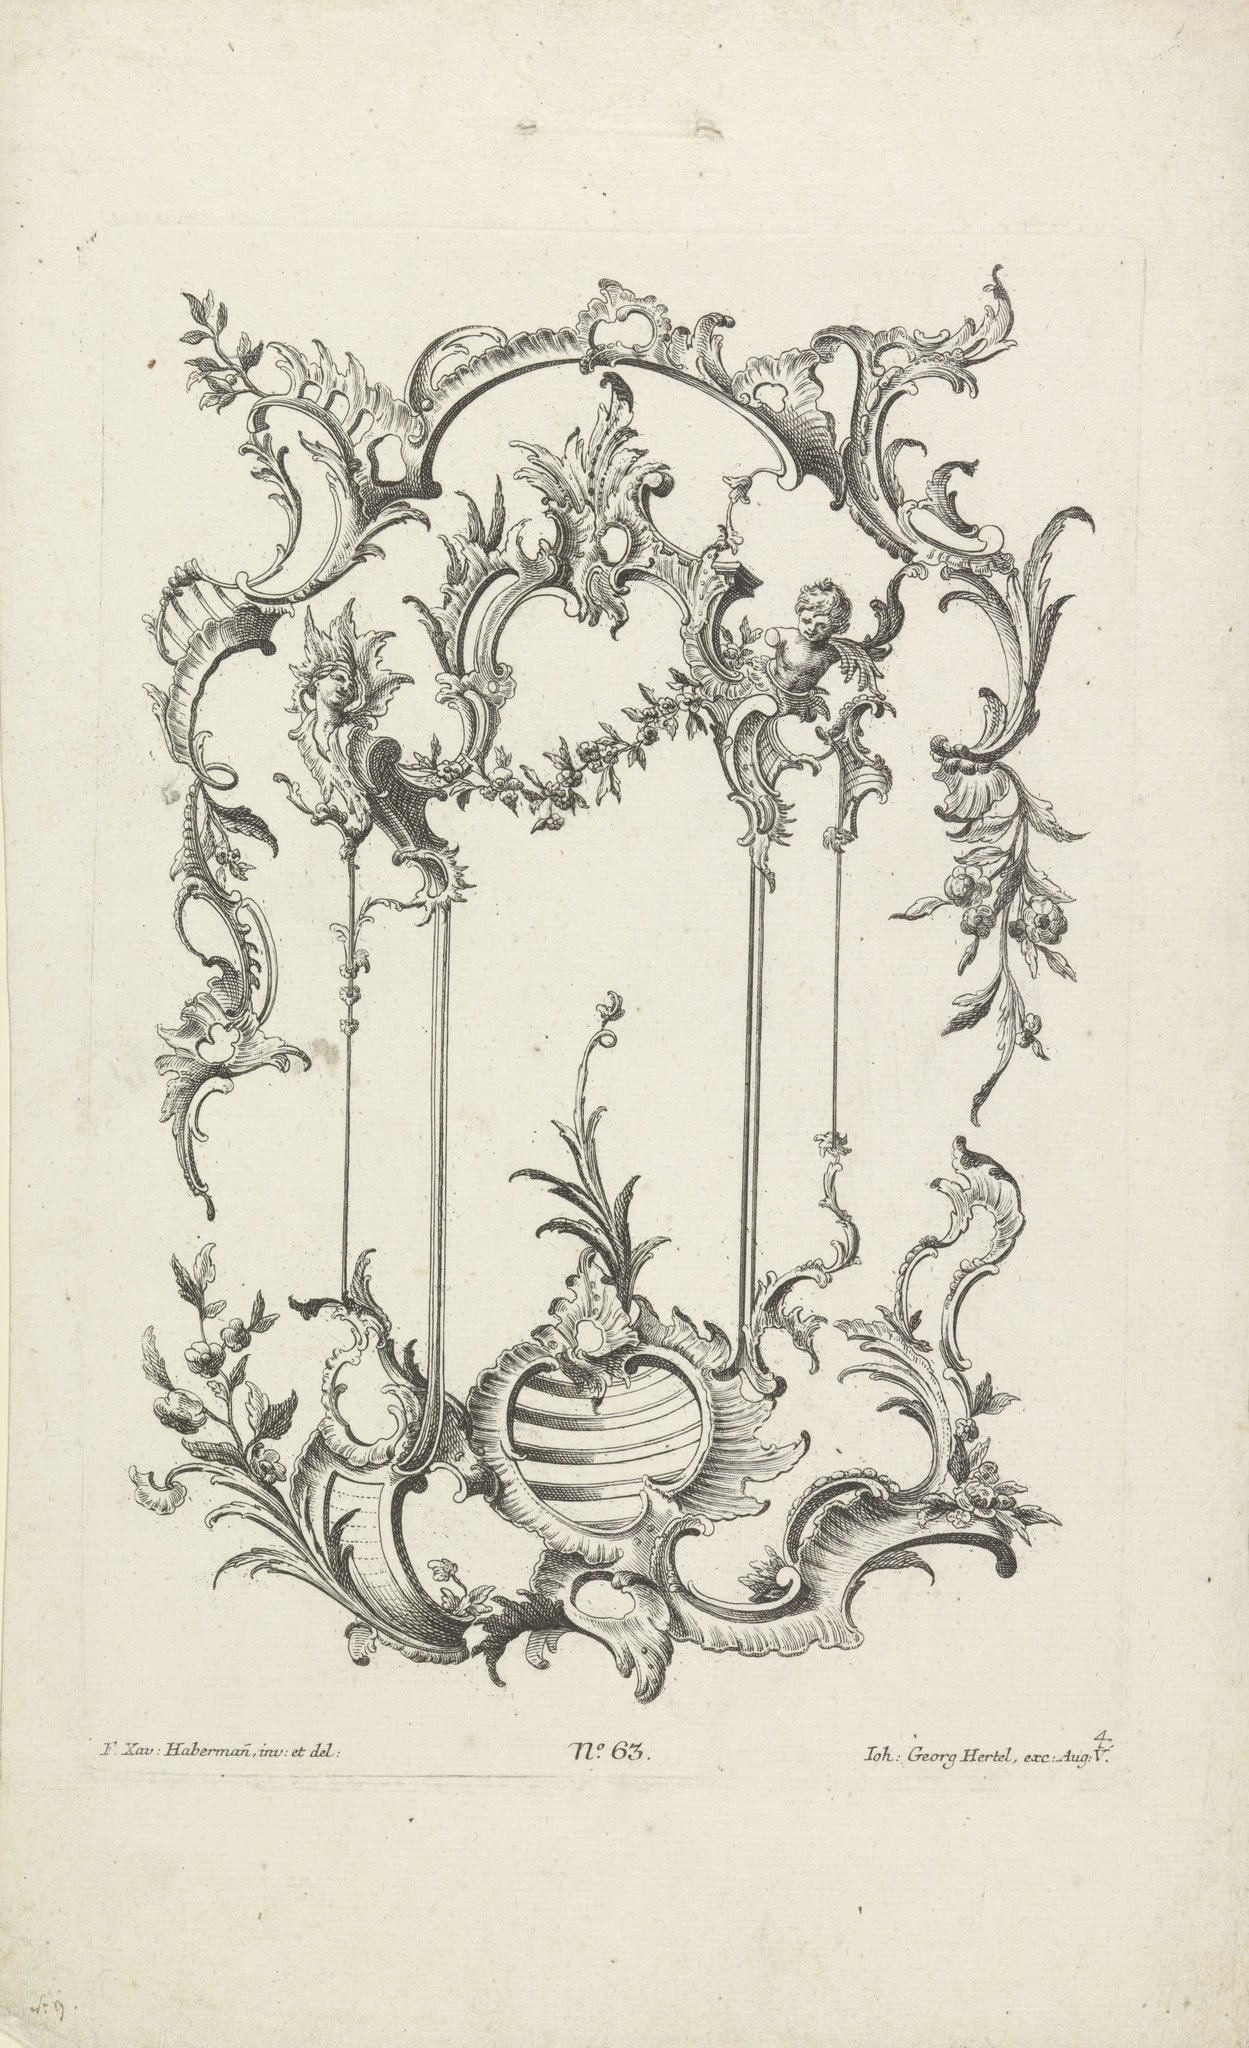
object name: print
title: Rocaille omlijstingen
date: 1731-1775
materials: paper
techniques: etching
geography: augsburg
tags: rocaille ornament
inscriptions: collector's mark: Lugt 2228, collector's mark: Lugt 2760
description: Rocaille ornamenten met bloemmotieven en figuren. Uitgeversnummer 63.